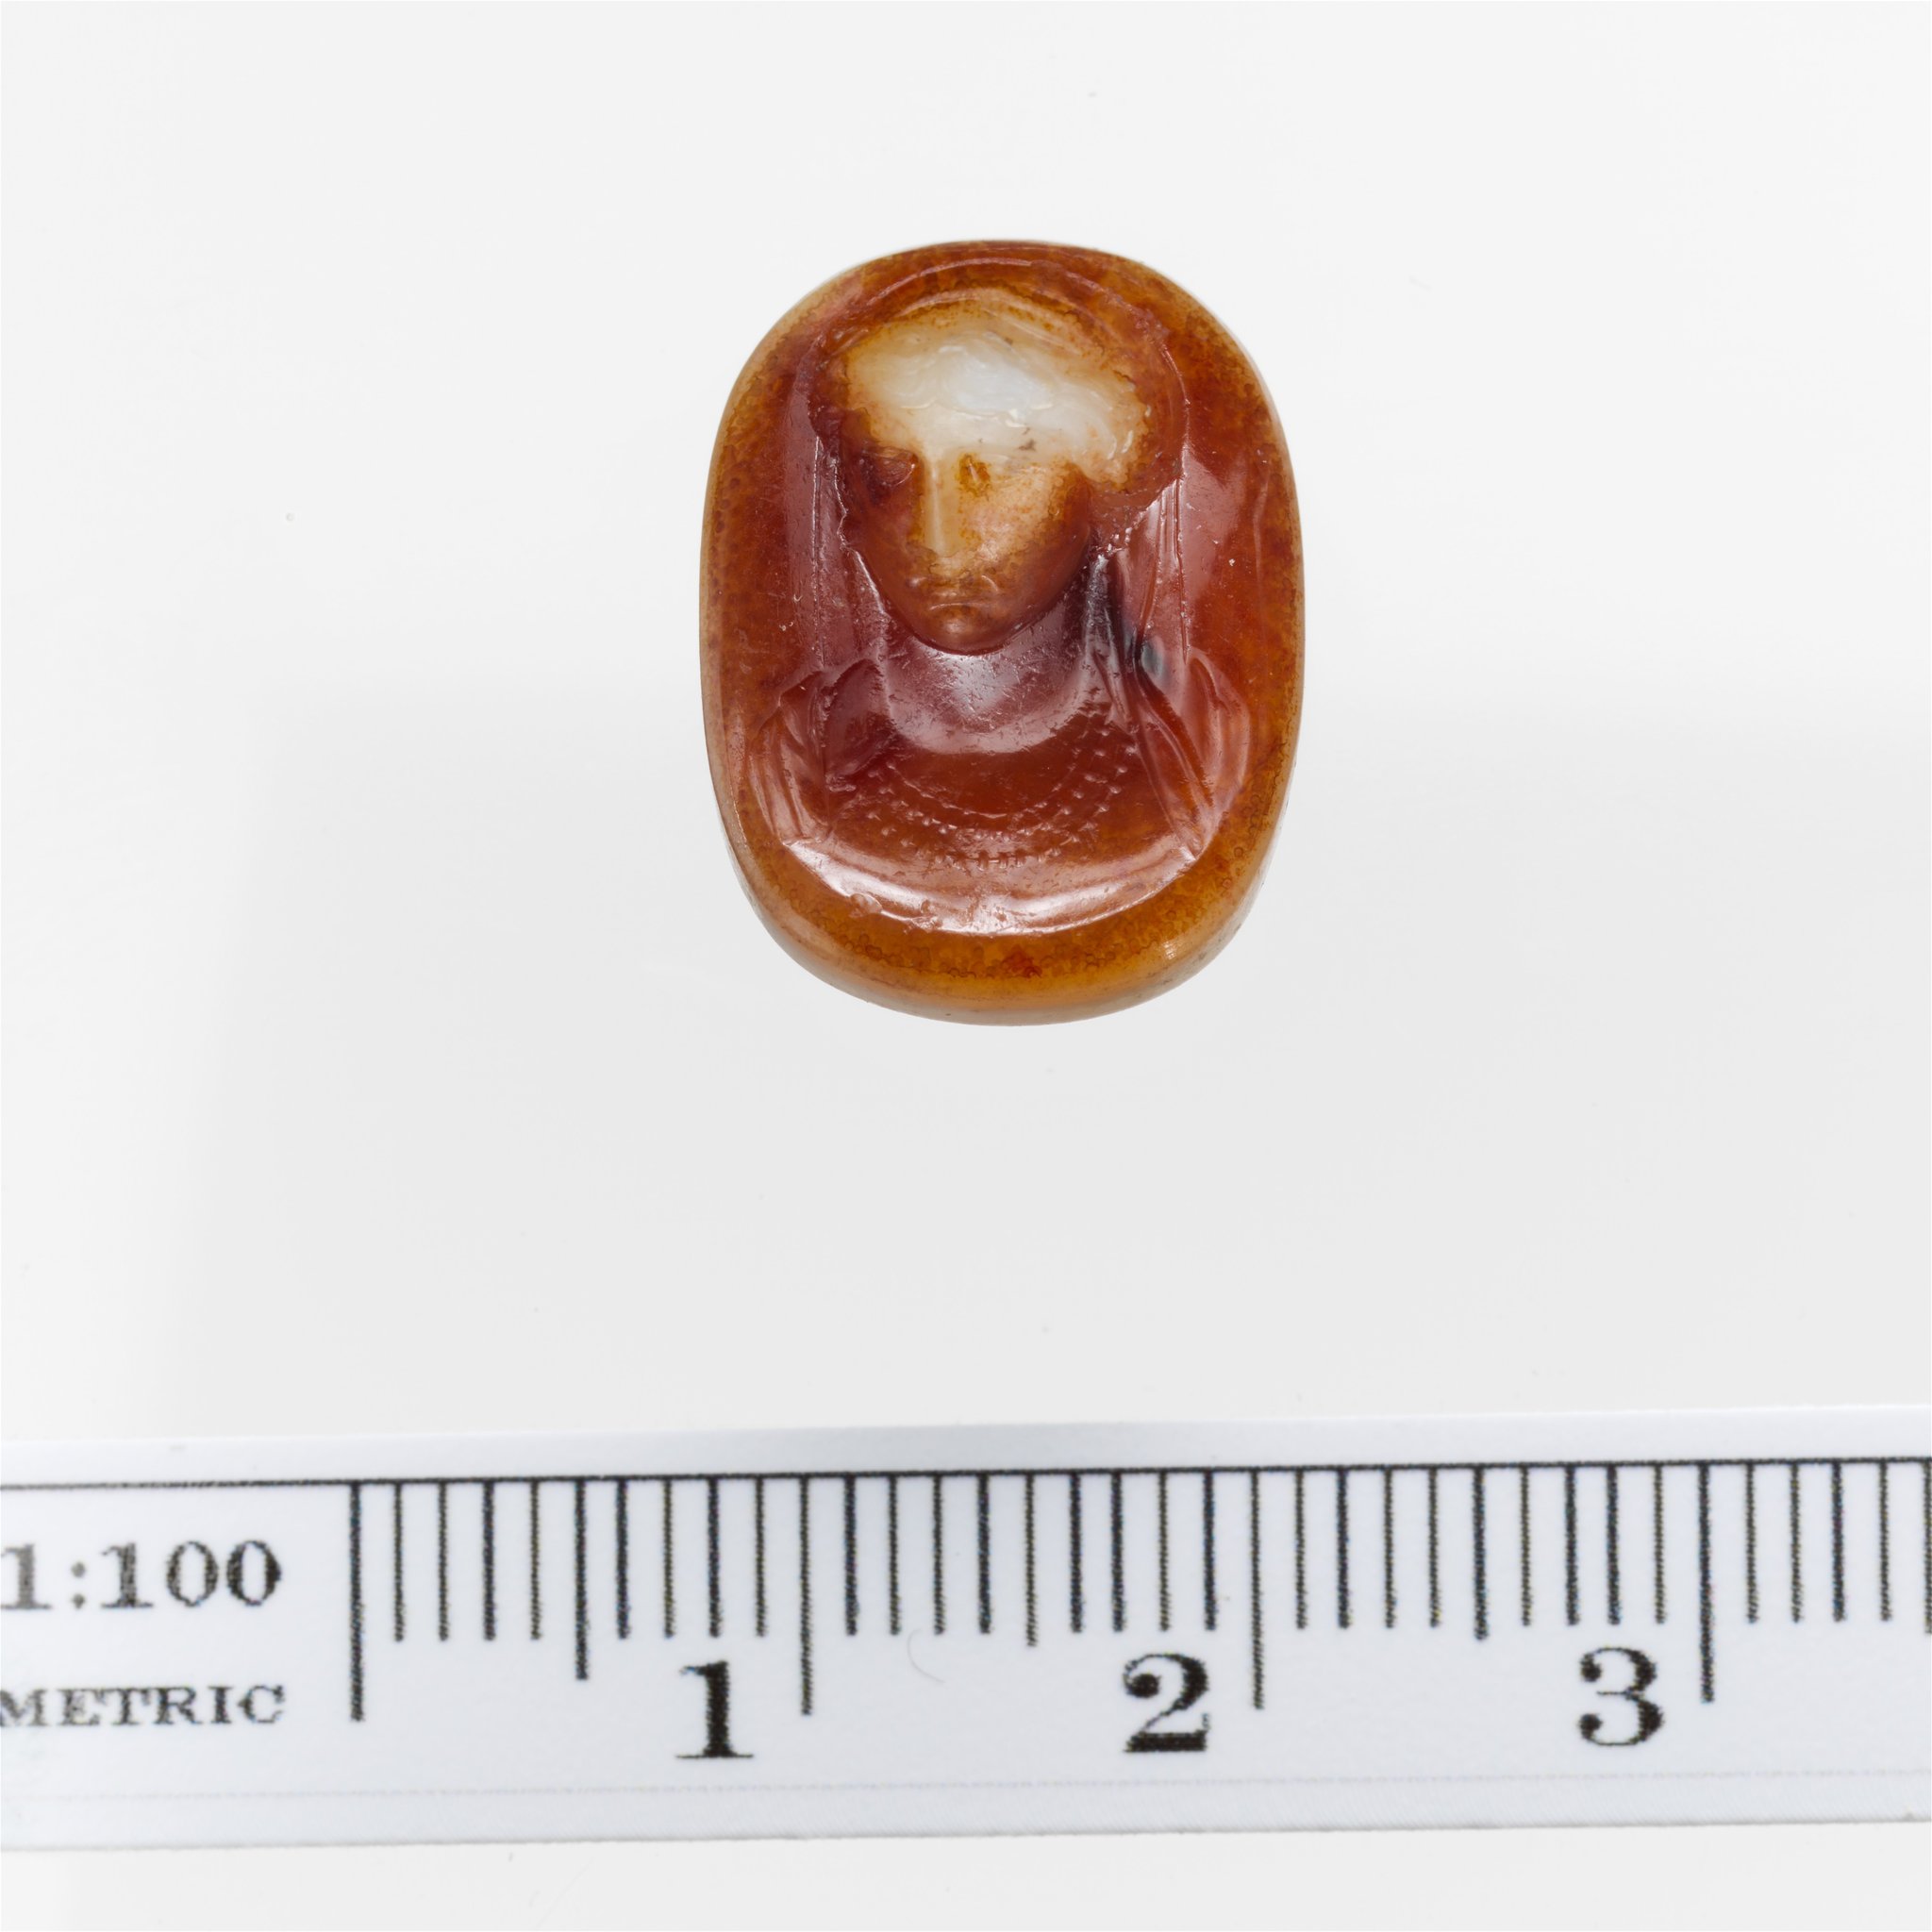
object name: cameo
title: Sardonyx ring stone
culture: roman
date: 1-100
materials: gemstone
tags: portraits,women